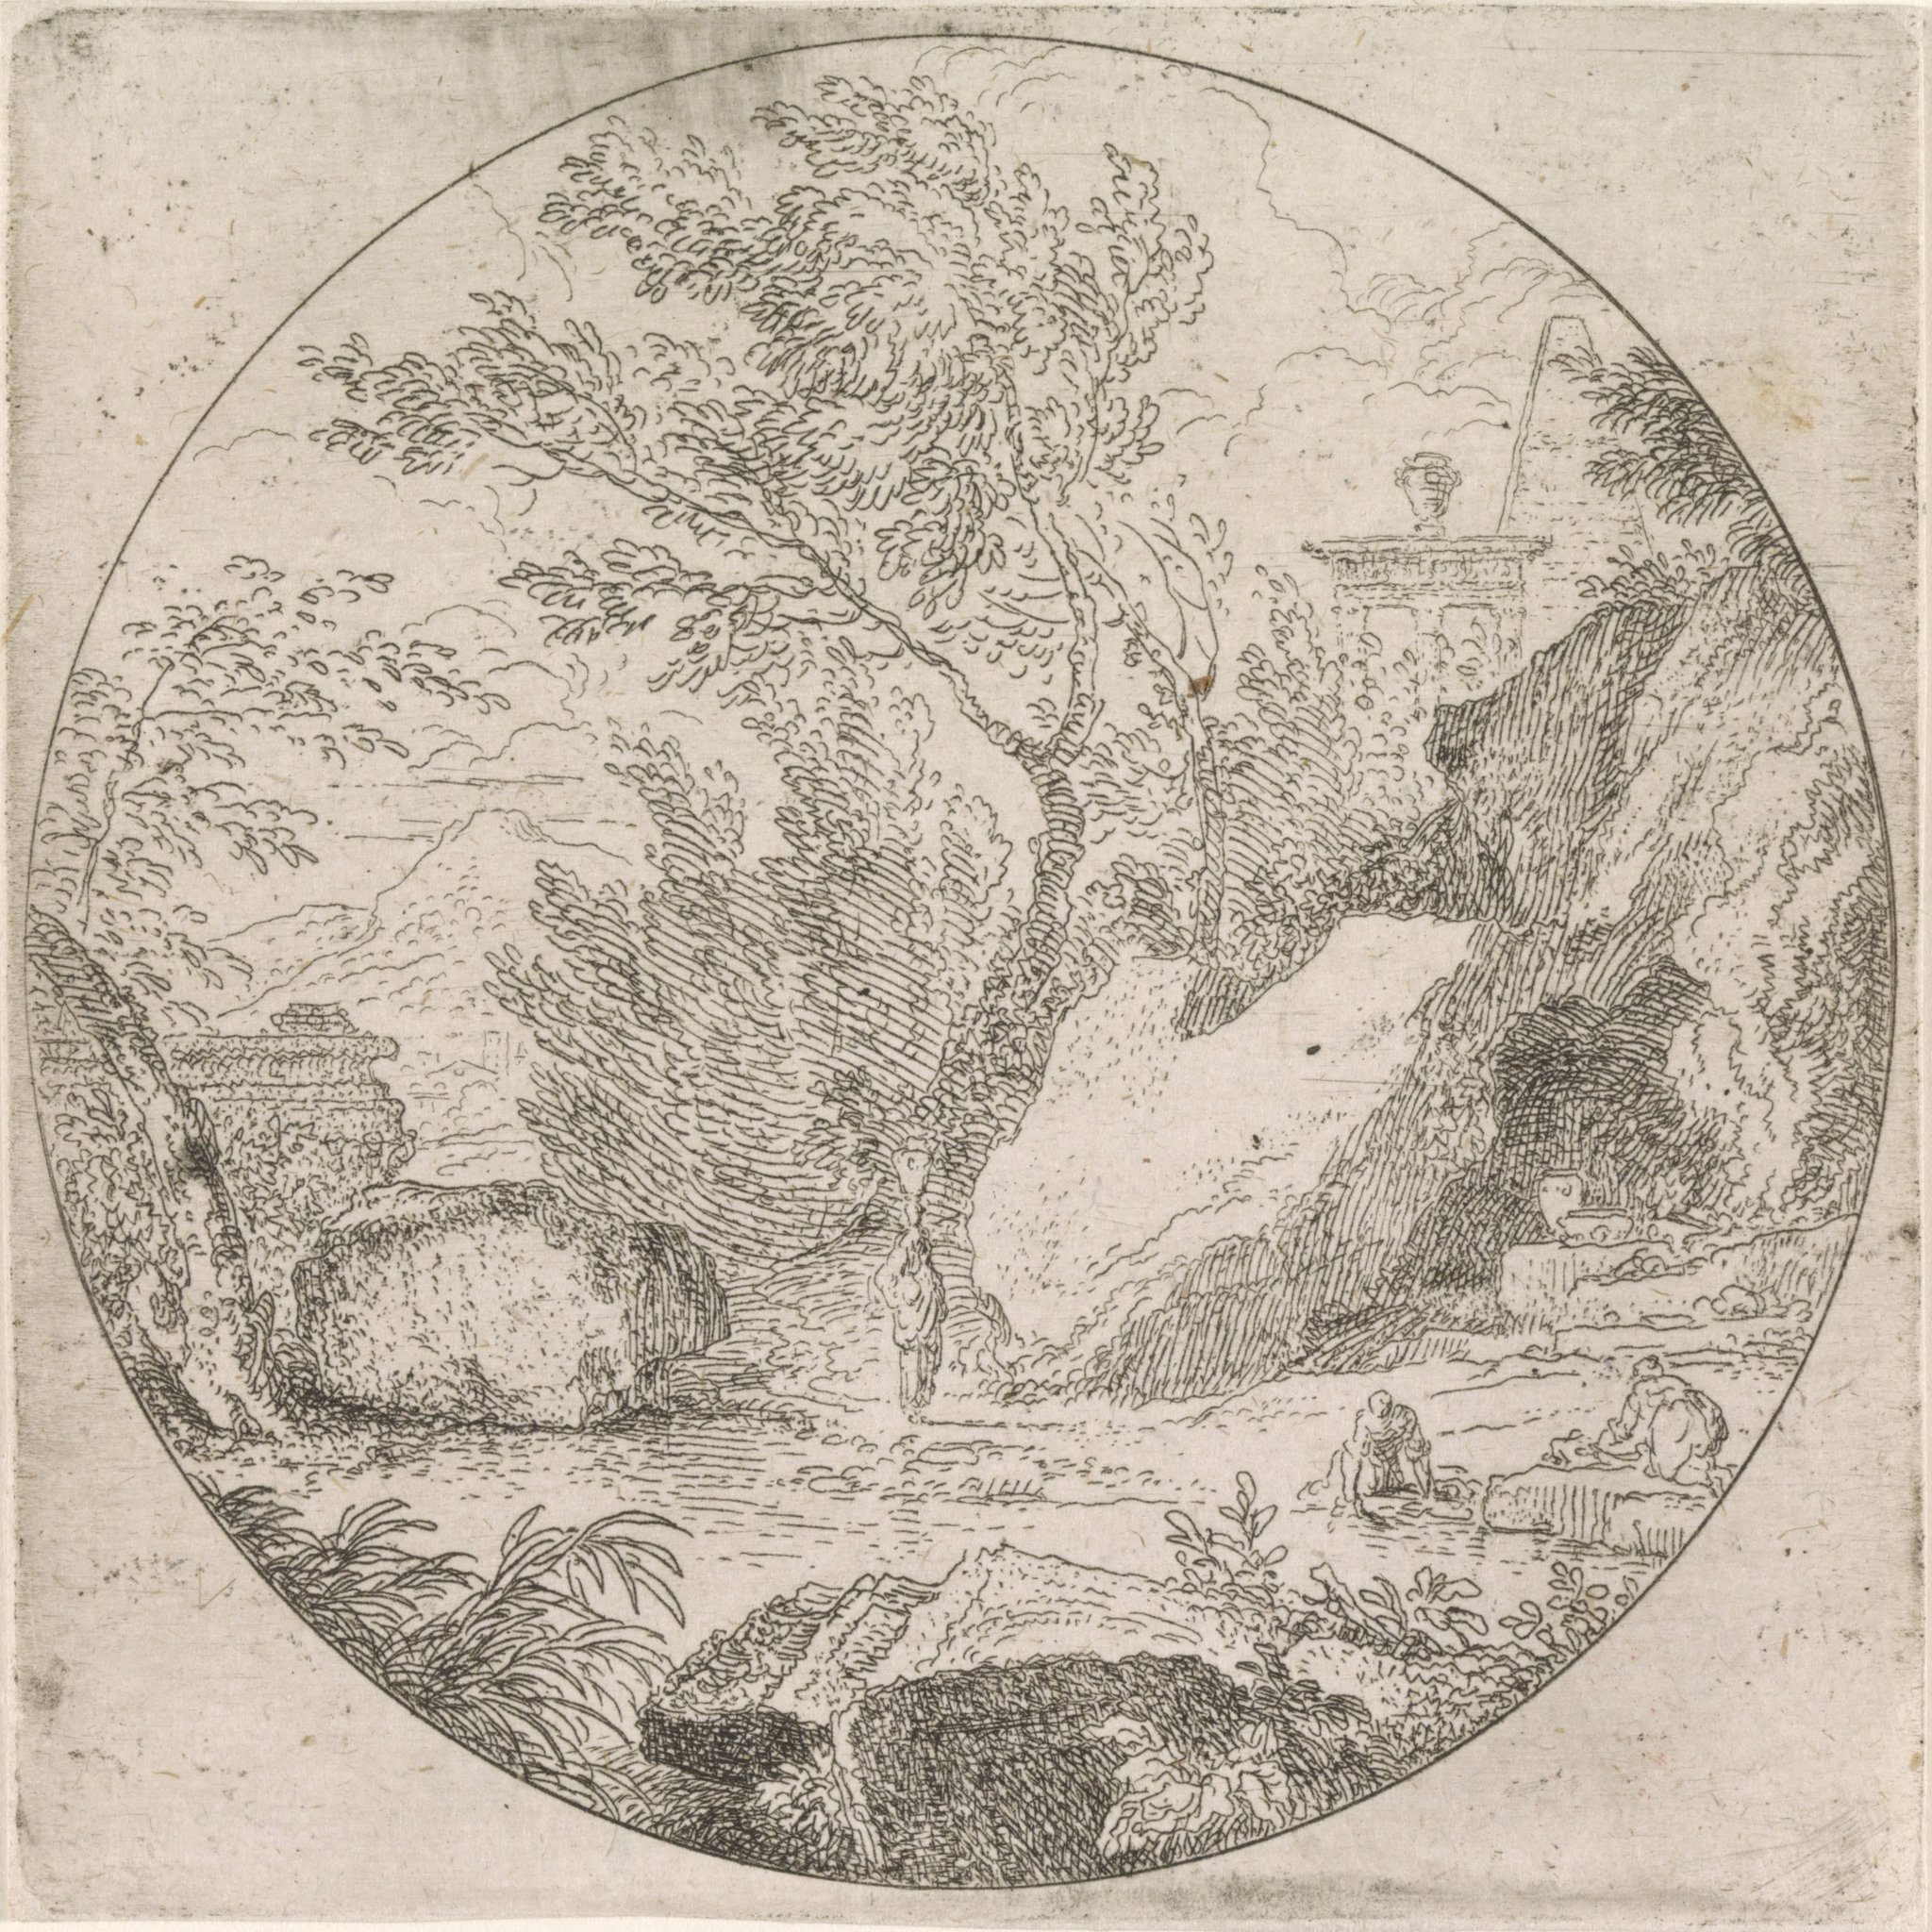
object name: print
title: Landschap met wassende vrouwen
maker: abraham genoels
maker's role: draughtsman, print maker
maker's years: 1640-1723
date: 1650-1724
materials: paper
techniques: etching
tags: triumphal arch, river (+ landscape with figures, staffage), wash house, home laundry, laundry room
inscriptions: collector's mark: Lugt 240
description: Enkele vrouwen doen de was in een rivier. Op de achtergrond een triomfboog.